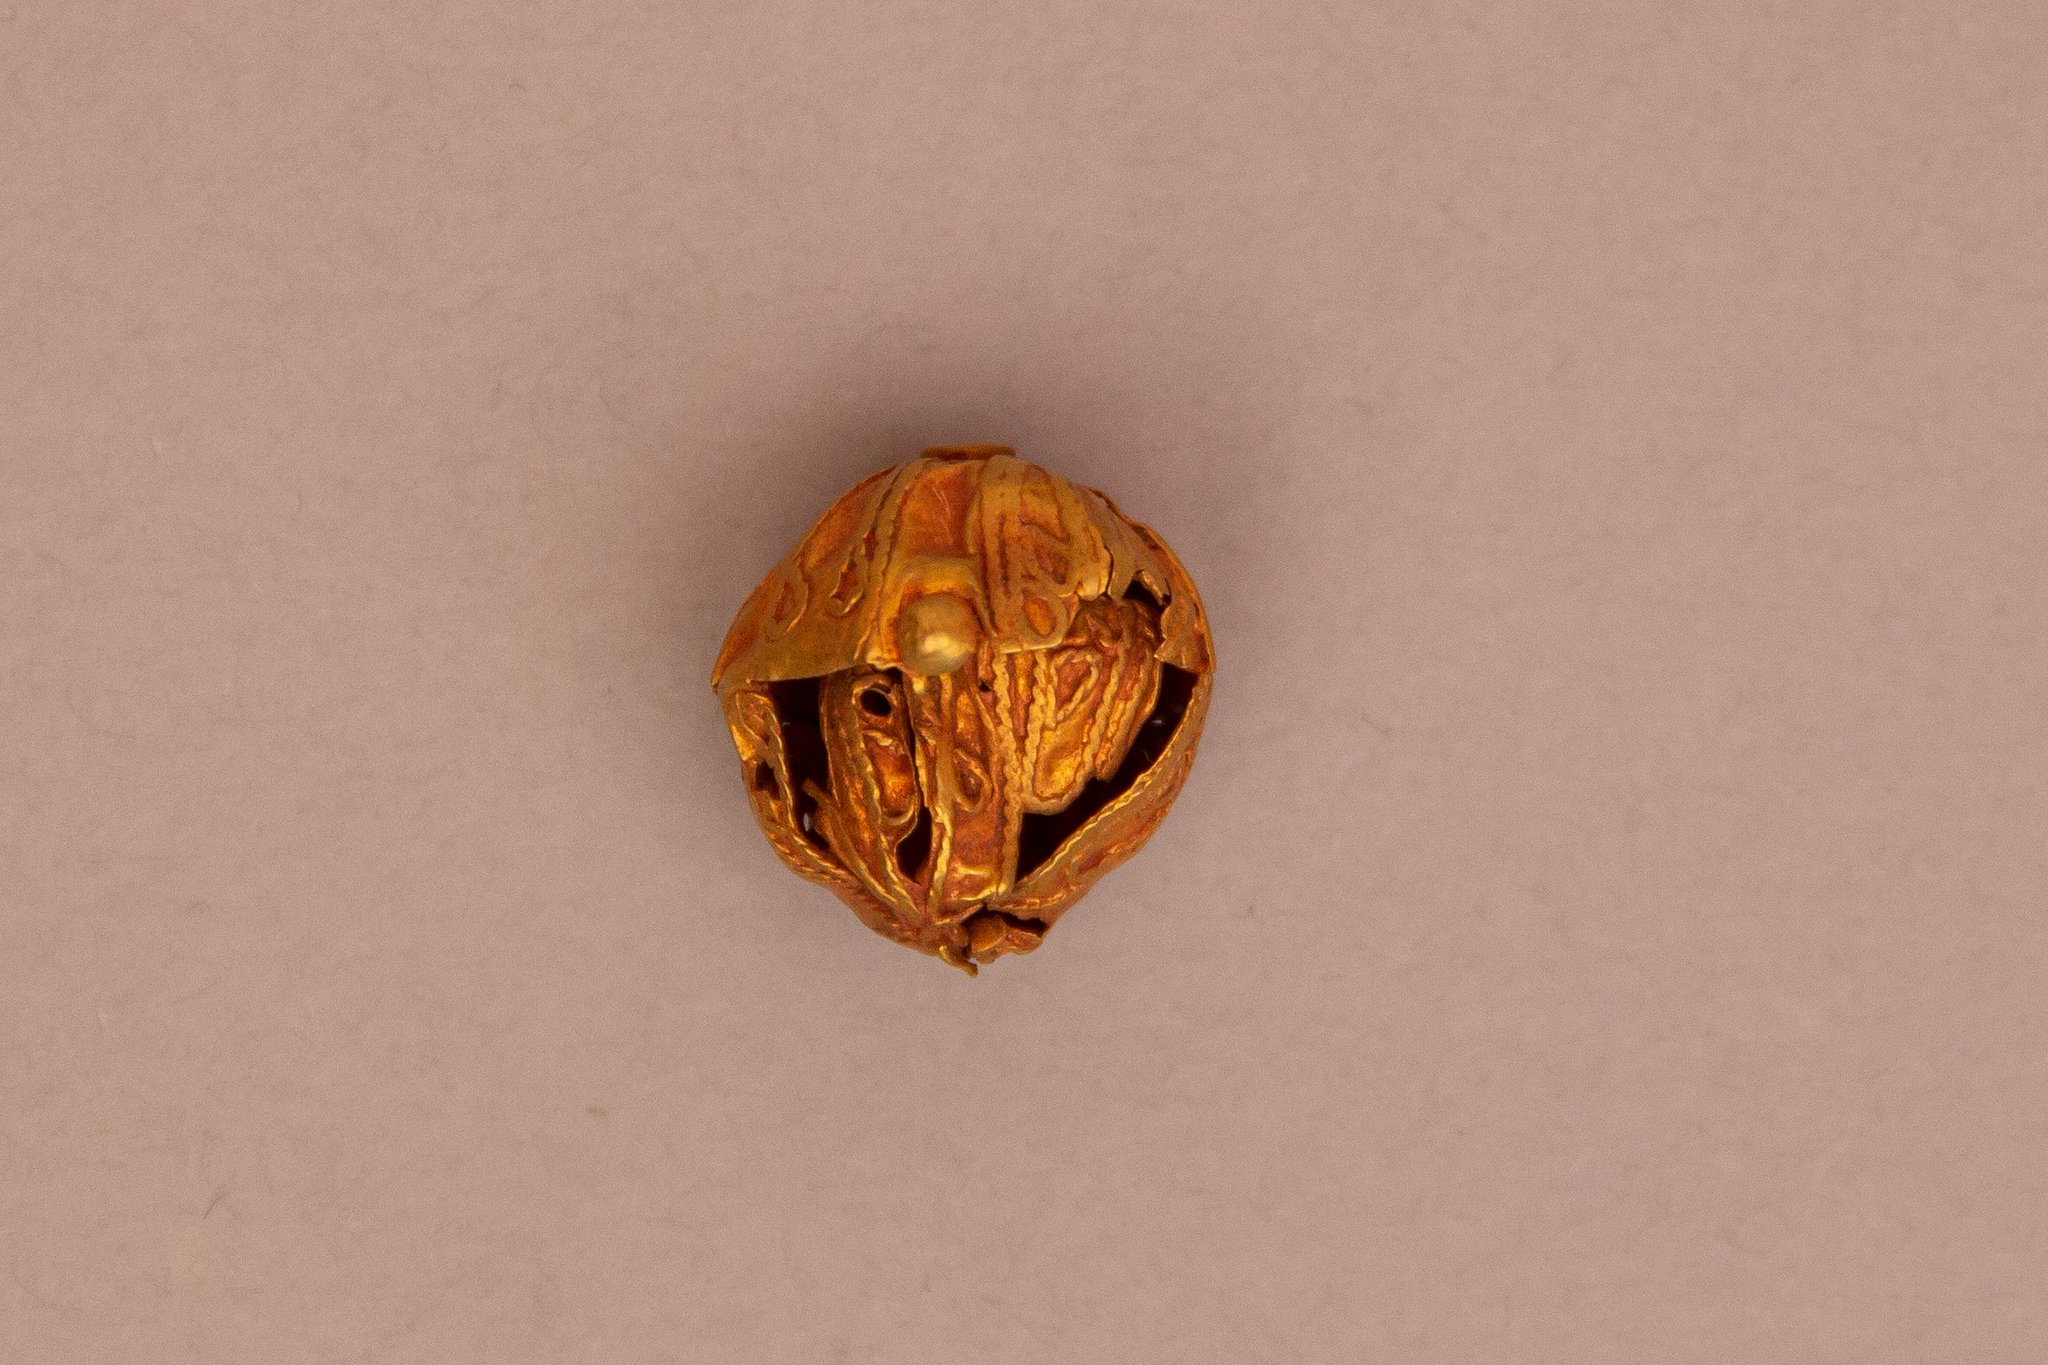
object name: bead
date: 1001-1100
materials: gold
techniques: filigree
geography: egypt or syria